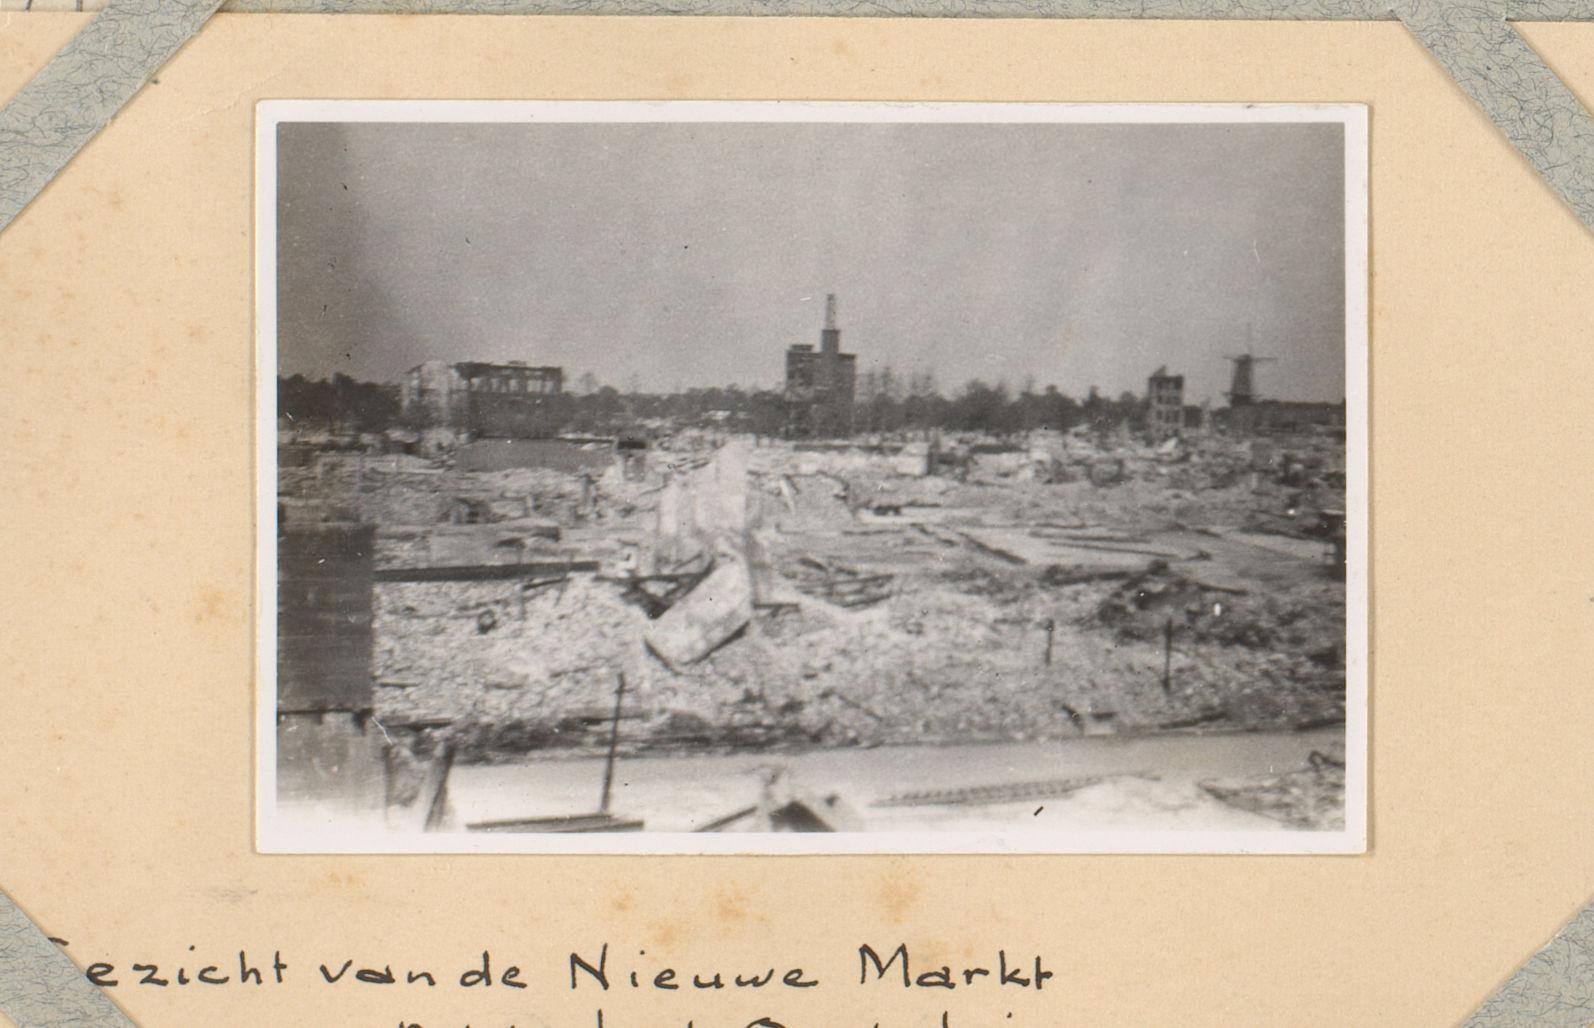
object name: photograph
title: Ruïnes aan het Oostplein, gezien vanaf de Nieuwe Markt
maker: j. nolte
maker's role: fotograaf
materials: photographic support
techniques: gelatin silver print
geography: rotterdam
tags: devastated, ruined place or city (~ warfare), ruin of a dwelling, house, castle, etc., rotterdam, rotterdam blitz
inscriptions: annotation: ‘Gezicht van de Nieuwe Markt/ naar het Oostplein.’